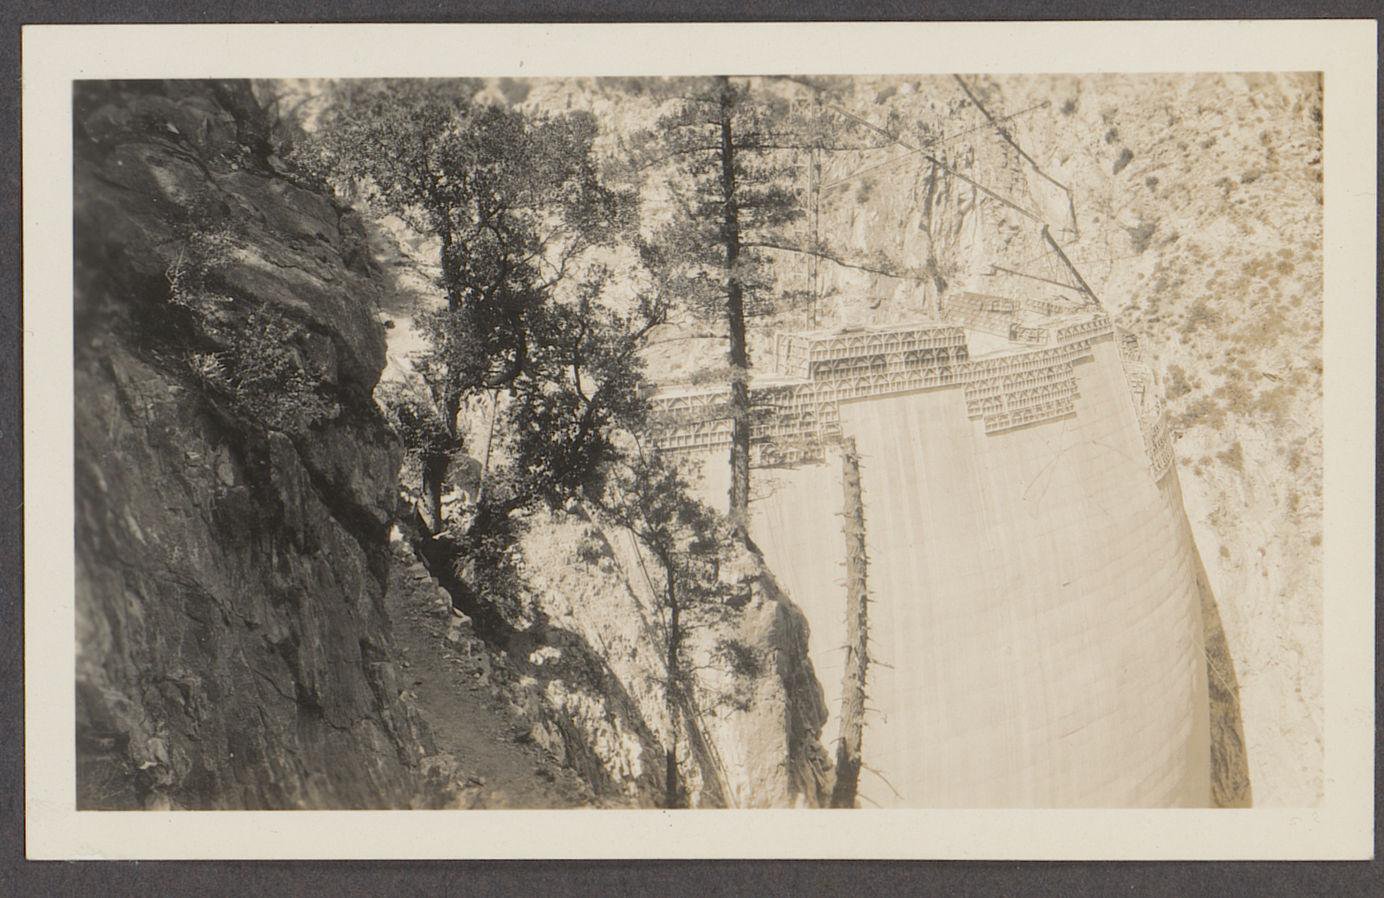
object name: photograph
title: Pacoima Dam in aanbouw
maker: Anonymous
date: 1928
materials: photographic support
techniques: gelatin silver print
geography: los angeles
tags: machines; parts of machines; tools and appliances, dam (in canal), mountains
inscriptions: annotation: ‘Pacoima dam’